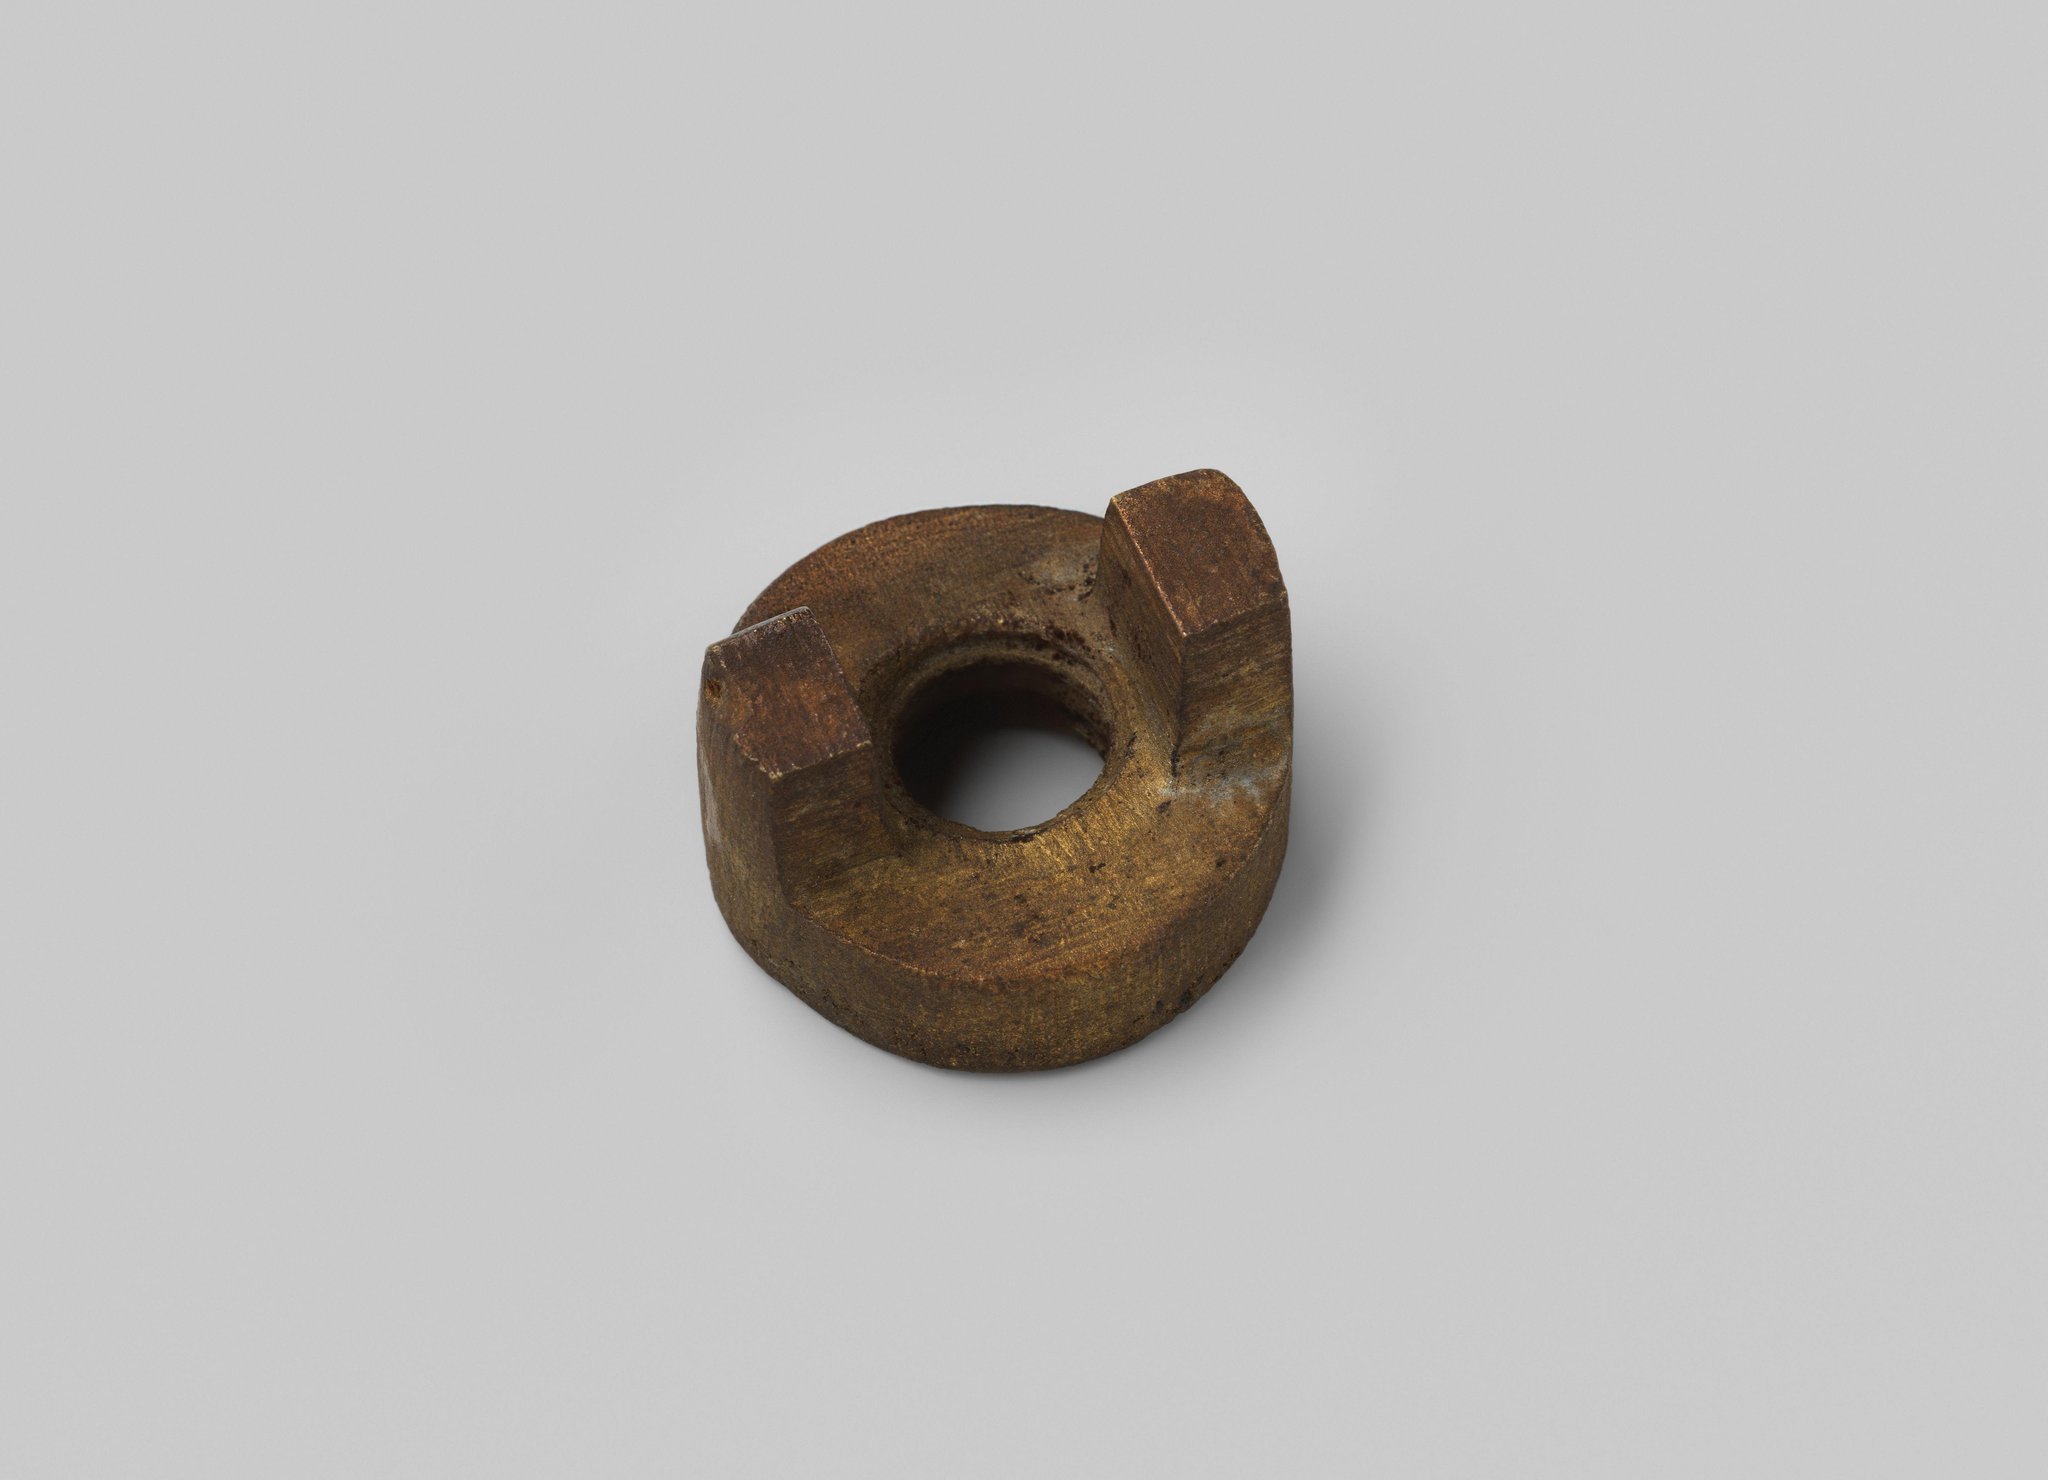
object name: nut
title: Moer uit het wrak van de Oost-Indiëvaarder Hollandia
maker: Anonymous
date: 1743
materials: copper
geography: netherlands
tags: verenigde oostindische compagnie, hollandia (schip), annet